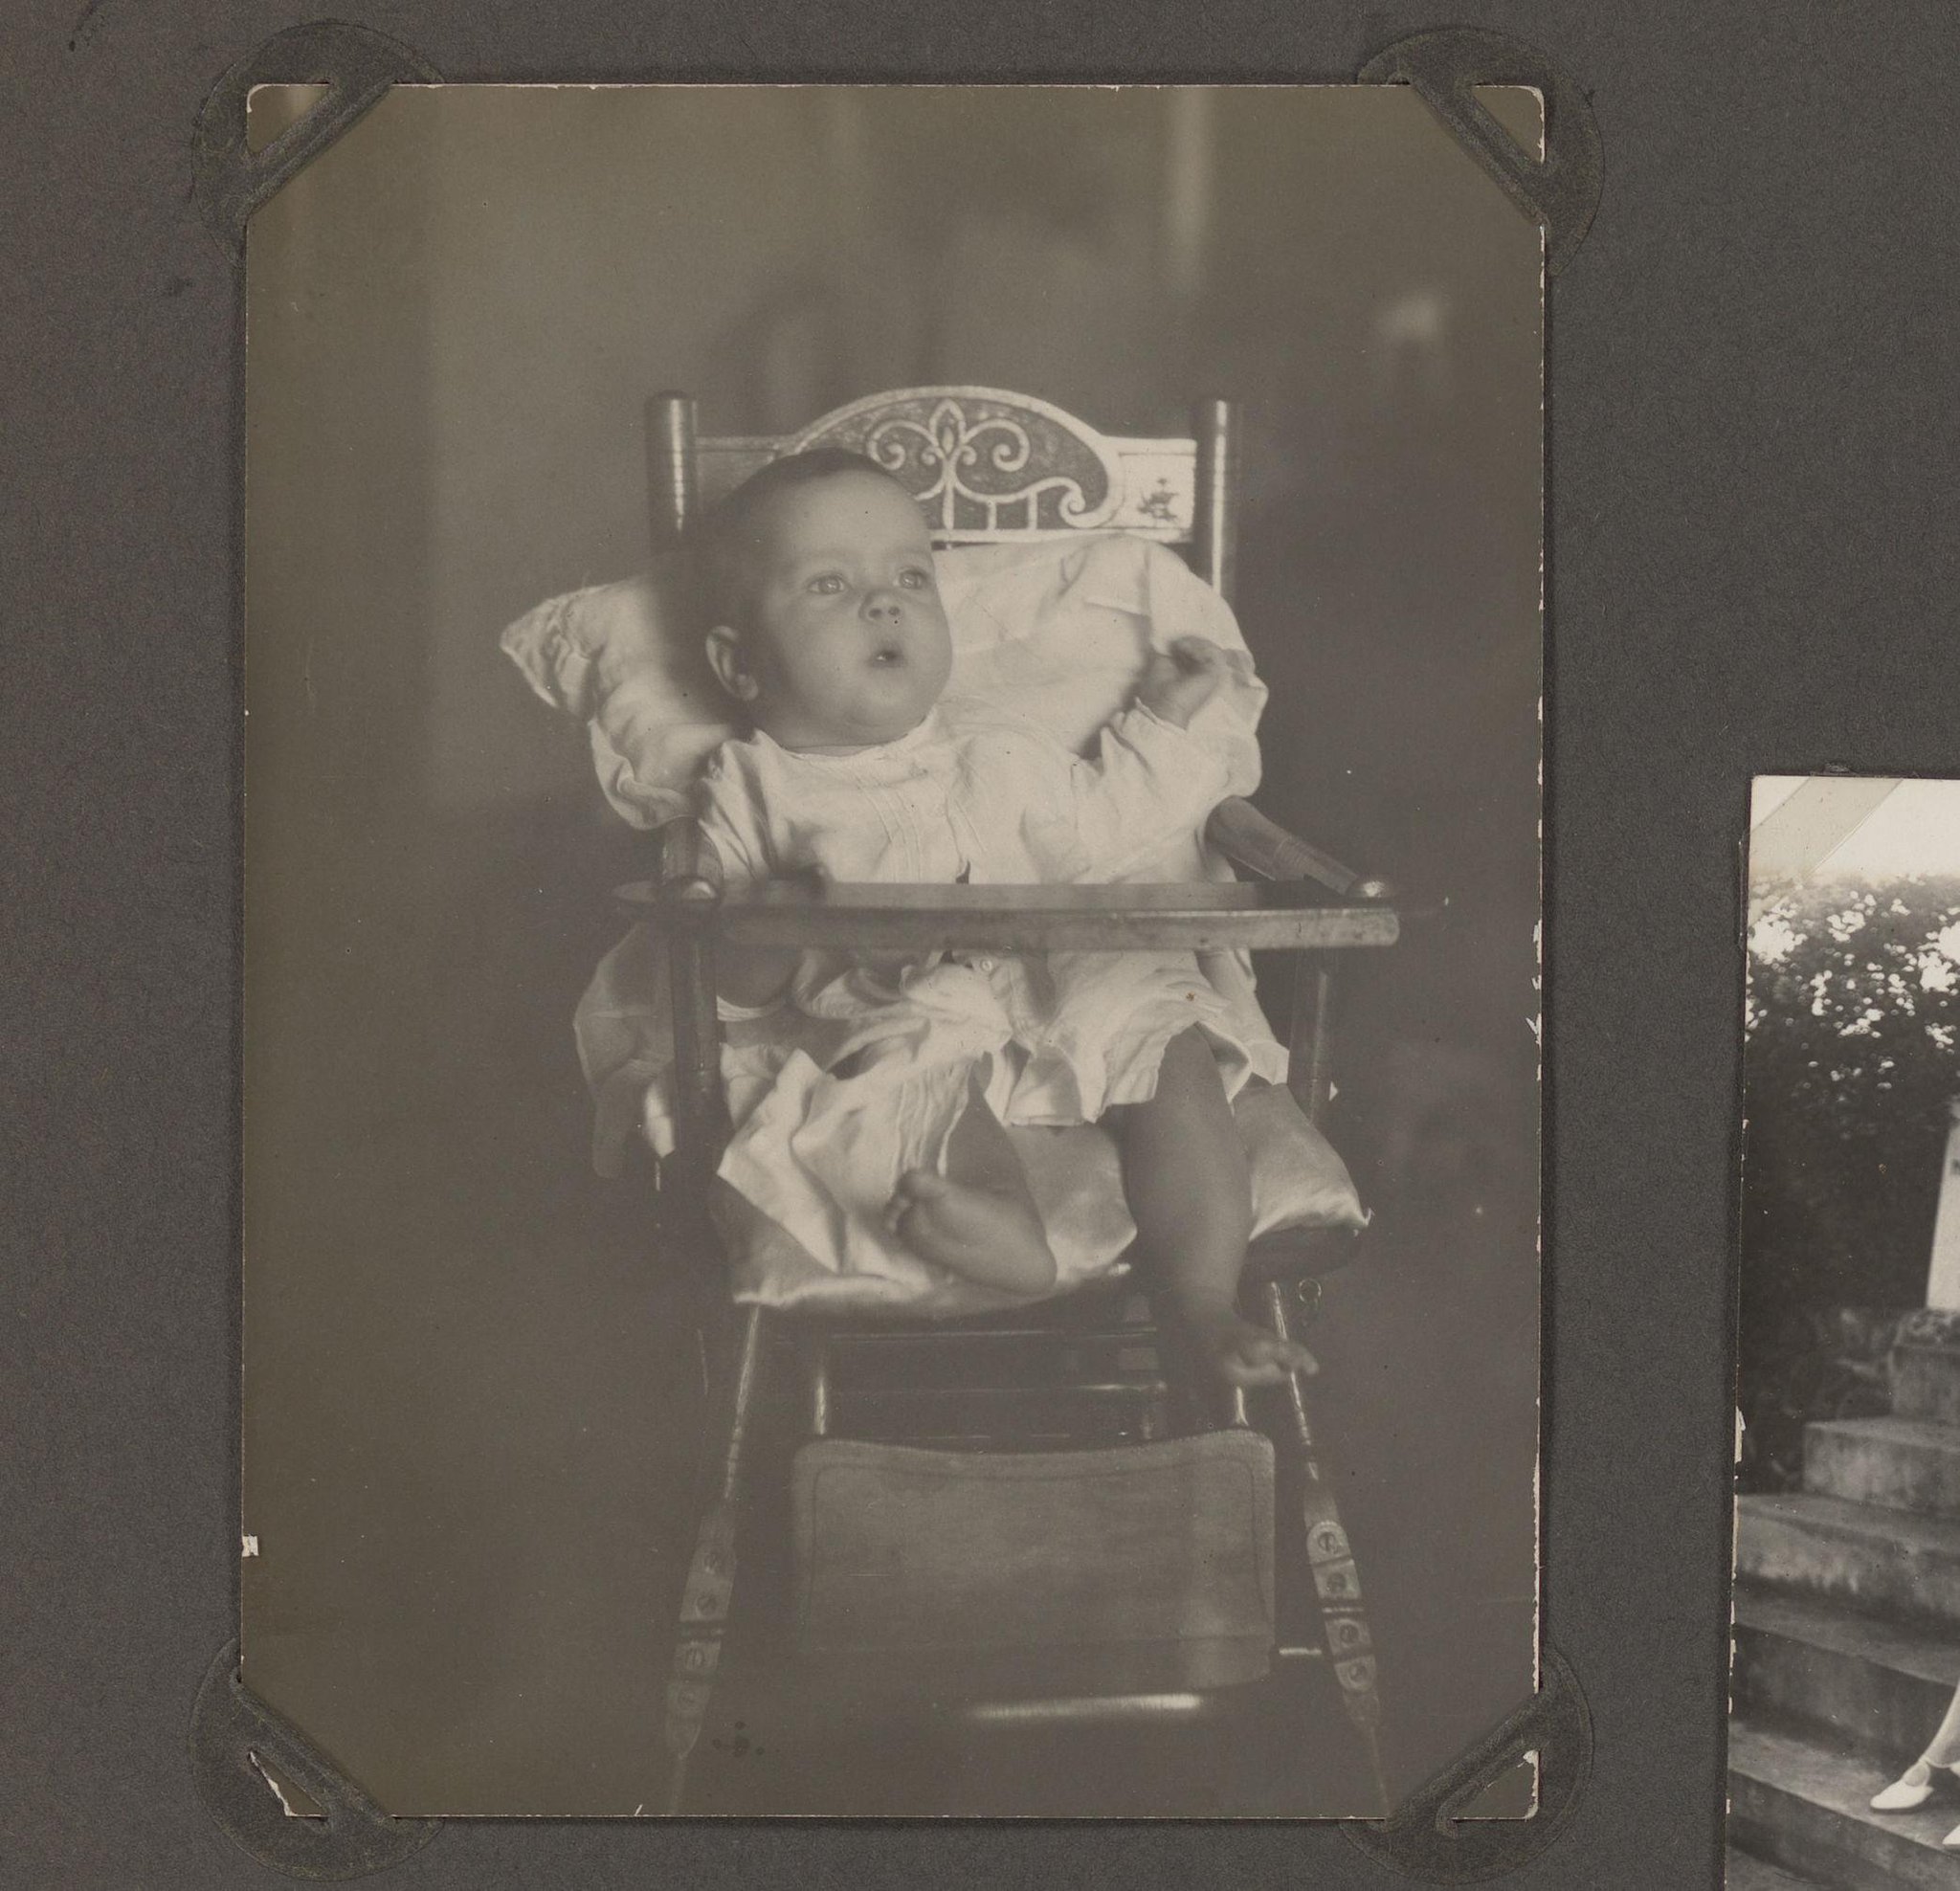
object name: photograph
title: Familiefoto van het gezin Jetten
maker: Anonymous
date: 1925-1927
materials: photographic support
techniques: photography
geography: suriname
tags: jetten, familie, moengo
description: Familiefoto van de kinderen Jetten met de ouders. Foto op een bladzijde van een los albumblad. Onderdeel van het ensemble met foto's van de familie van ingenieur Jetten in de mijnbouwstad Moengo in Suriname.